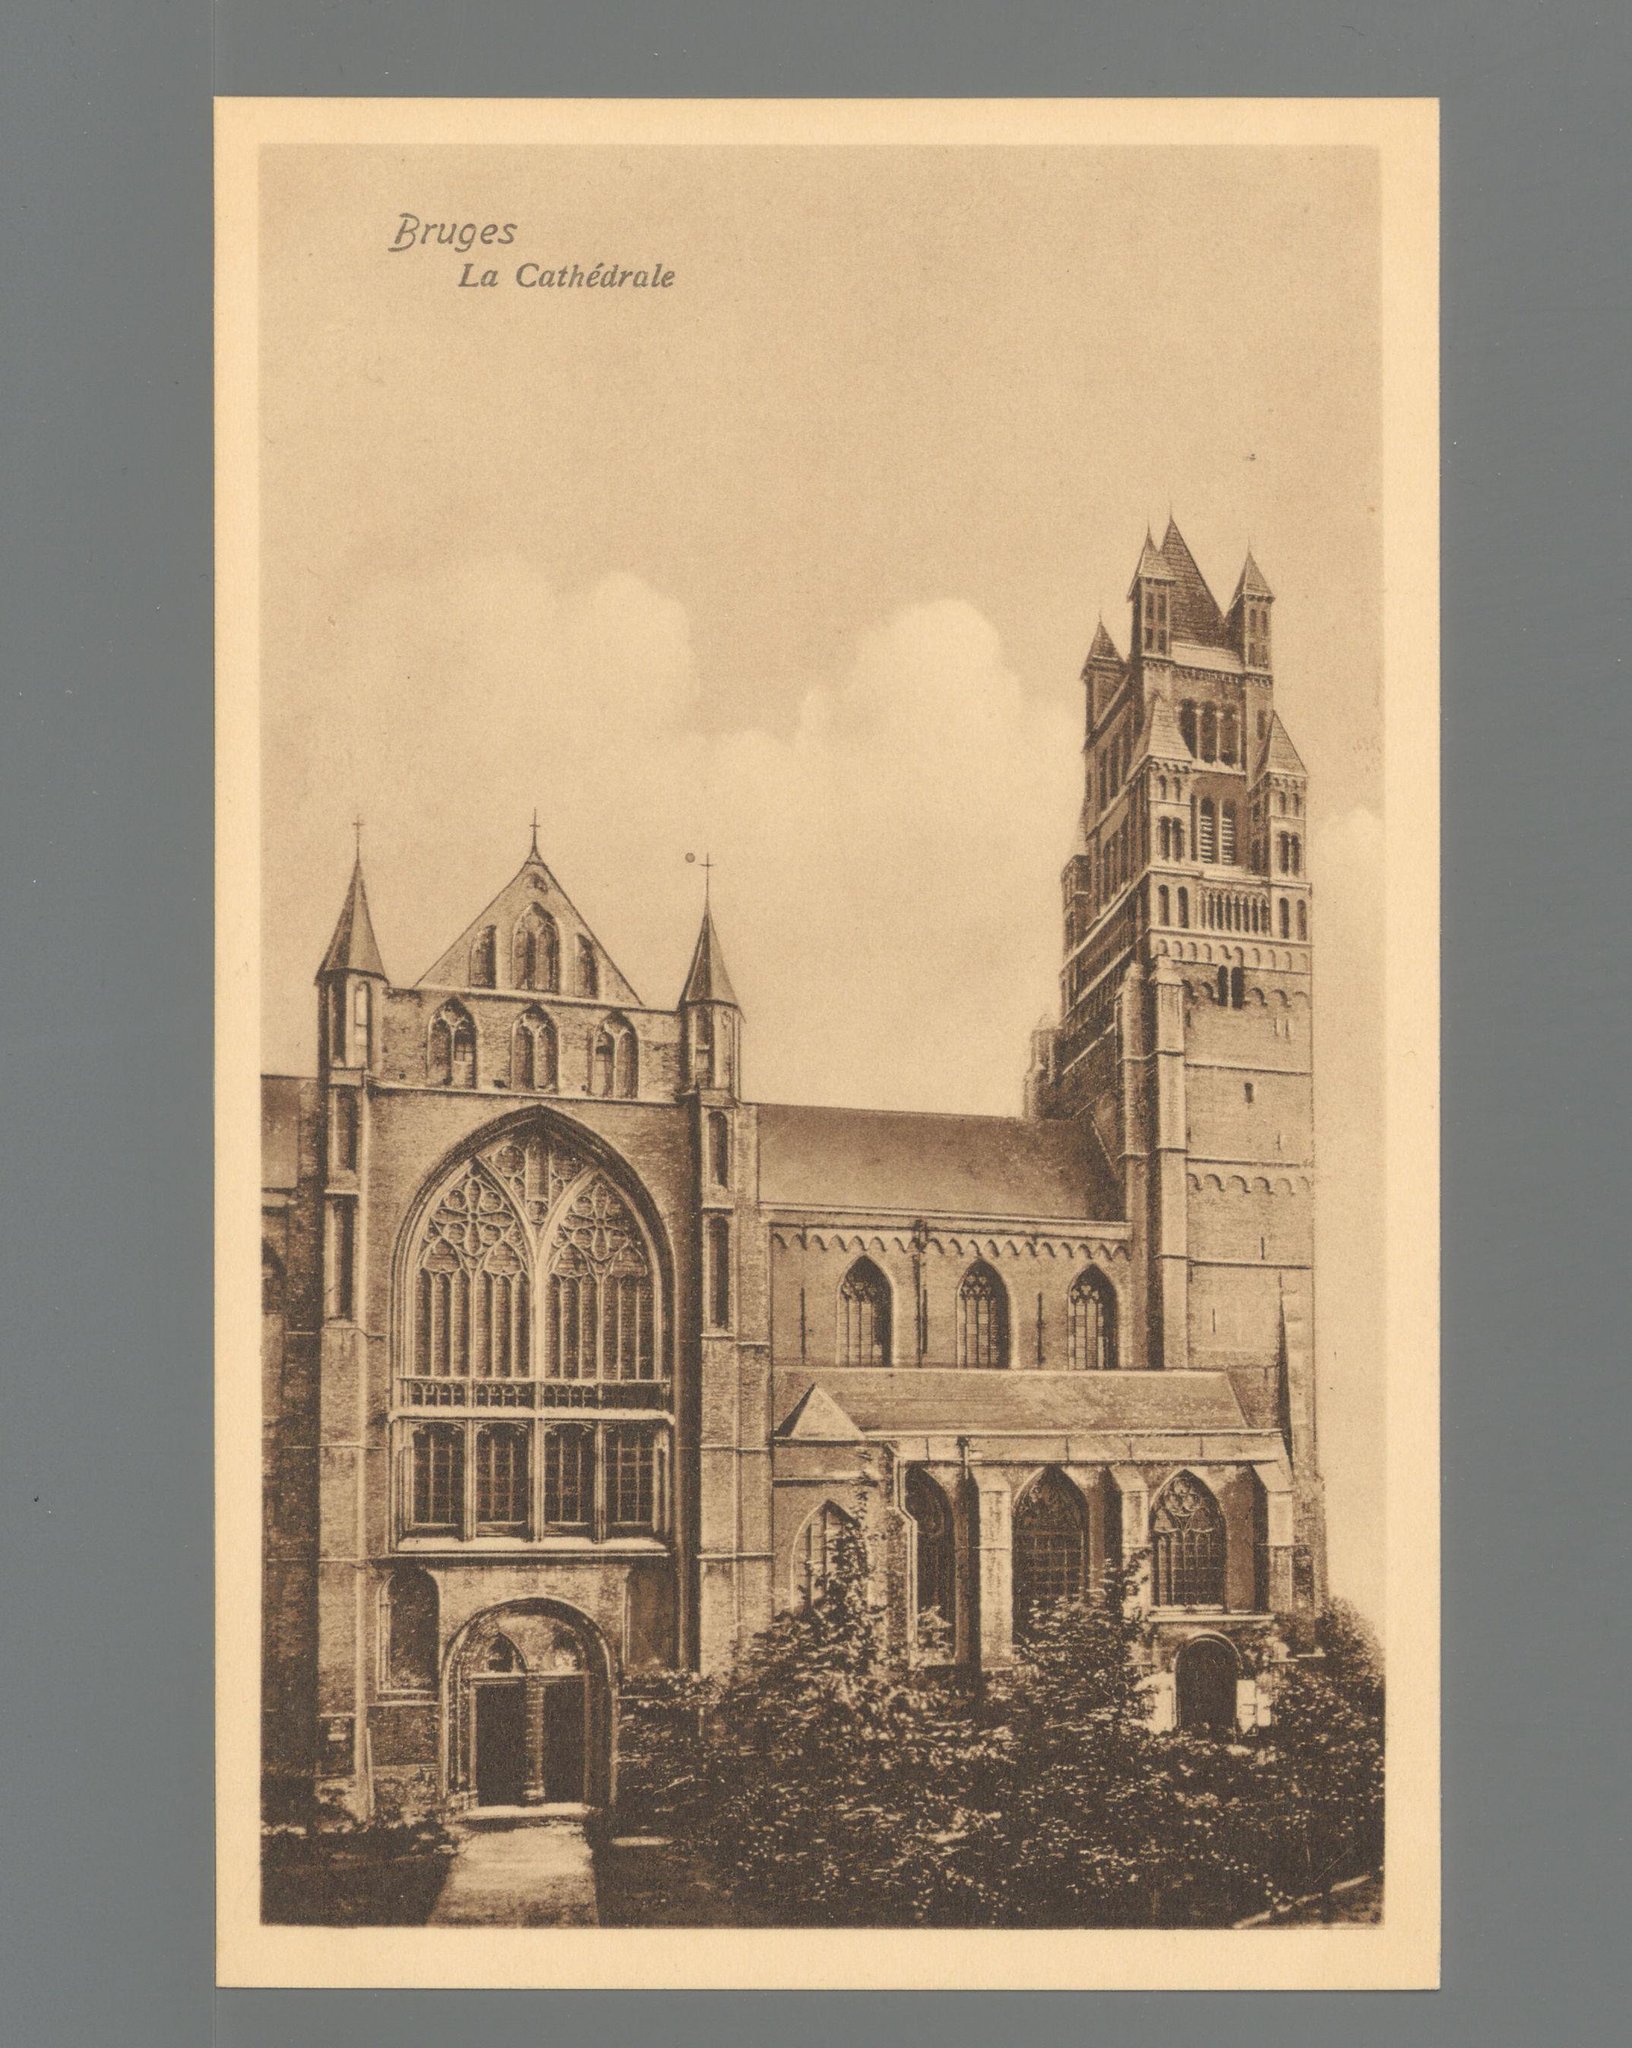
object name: ansichtkaart, prentbriefkaart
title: Bruges. La Cathédrale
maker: Anonymous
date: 1906-1930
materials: cardboard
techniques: photograph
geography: bruges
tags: church (exterior)